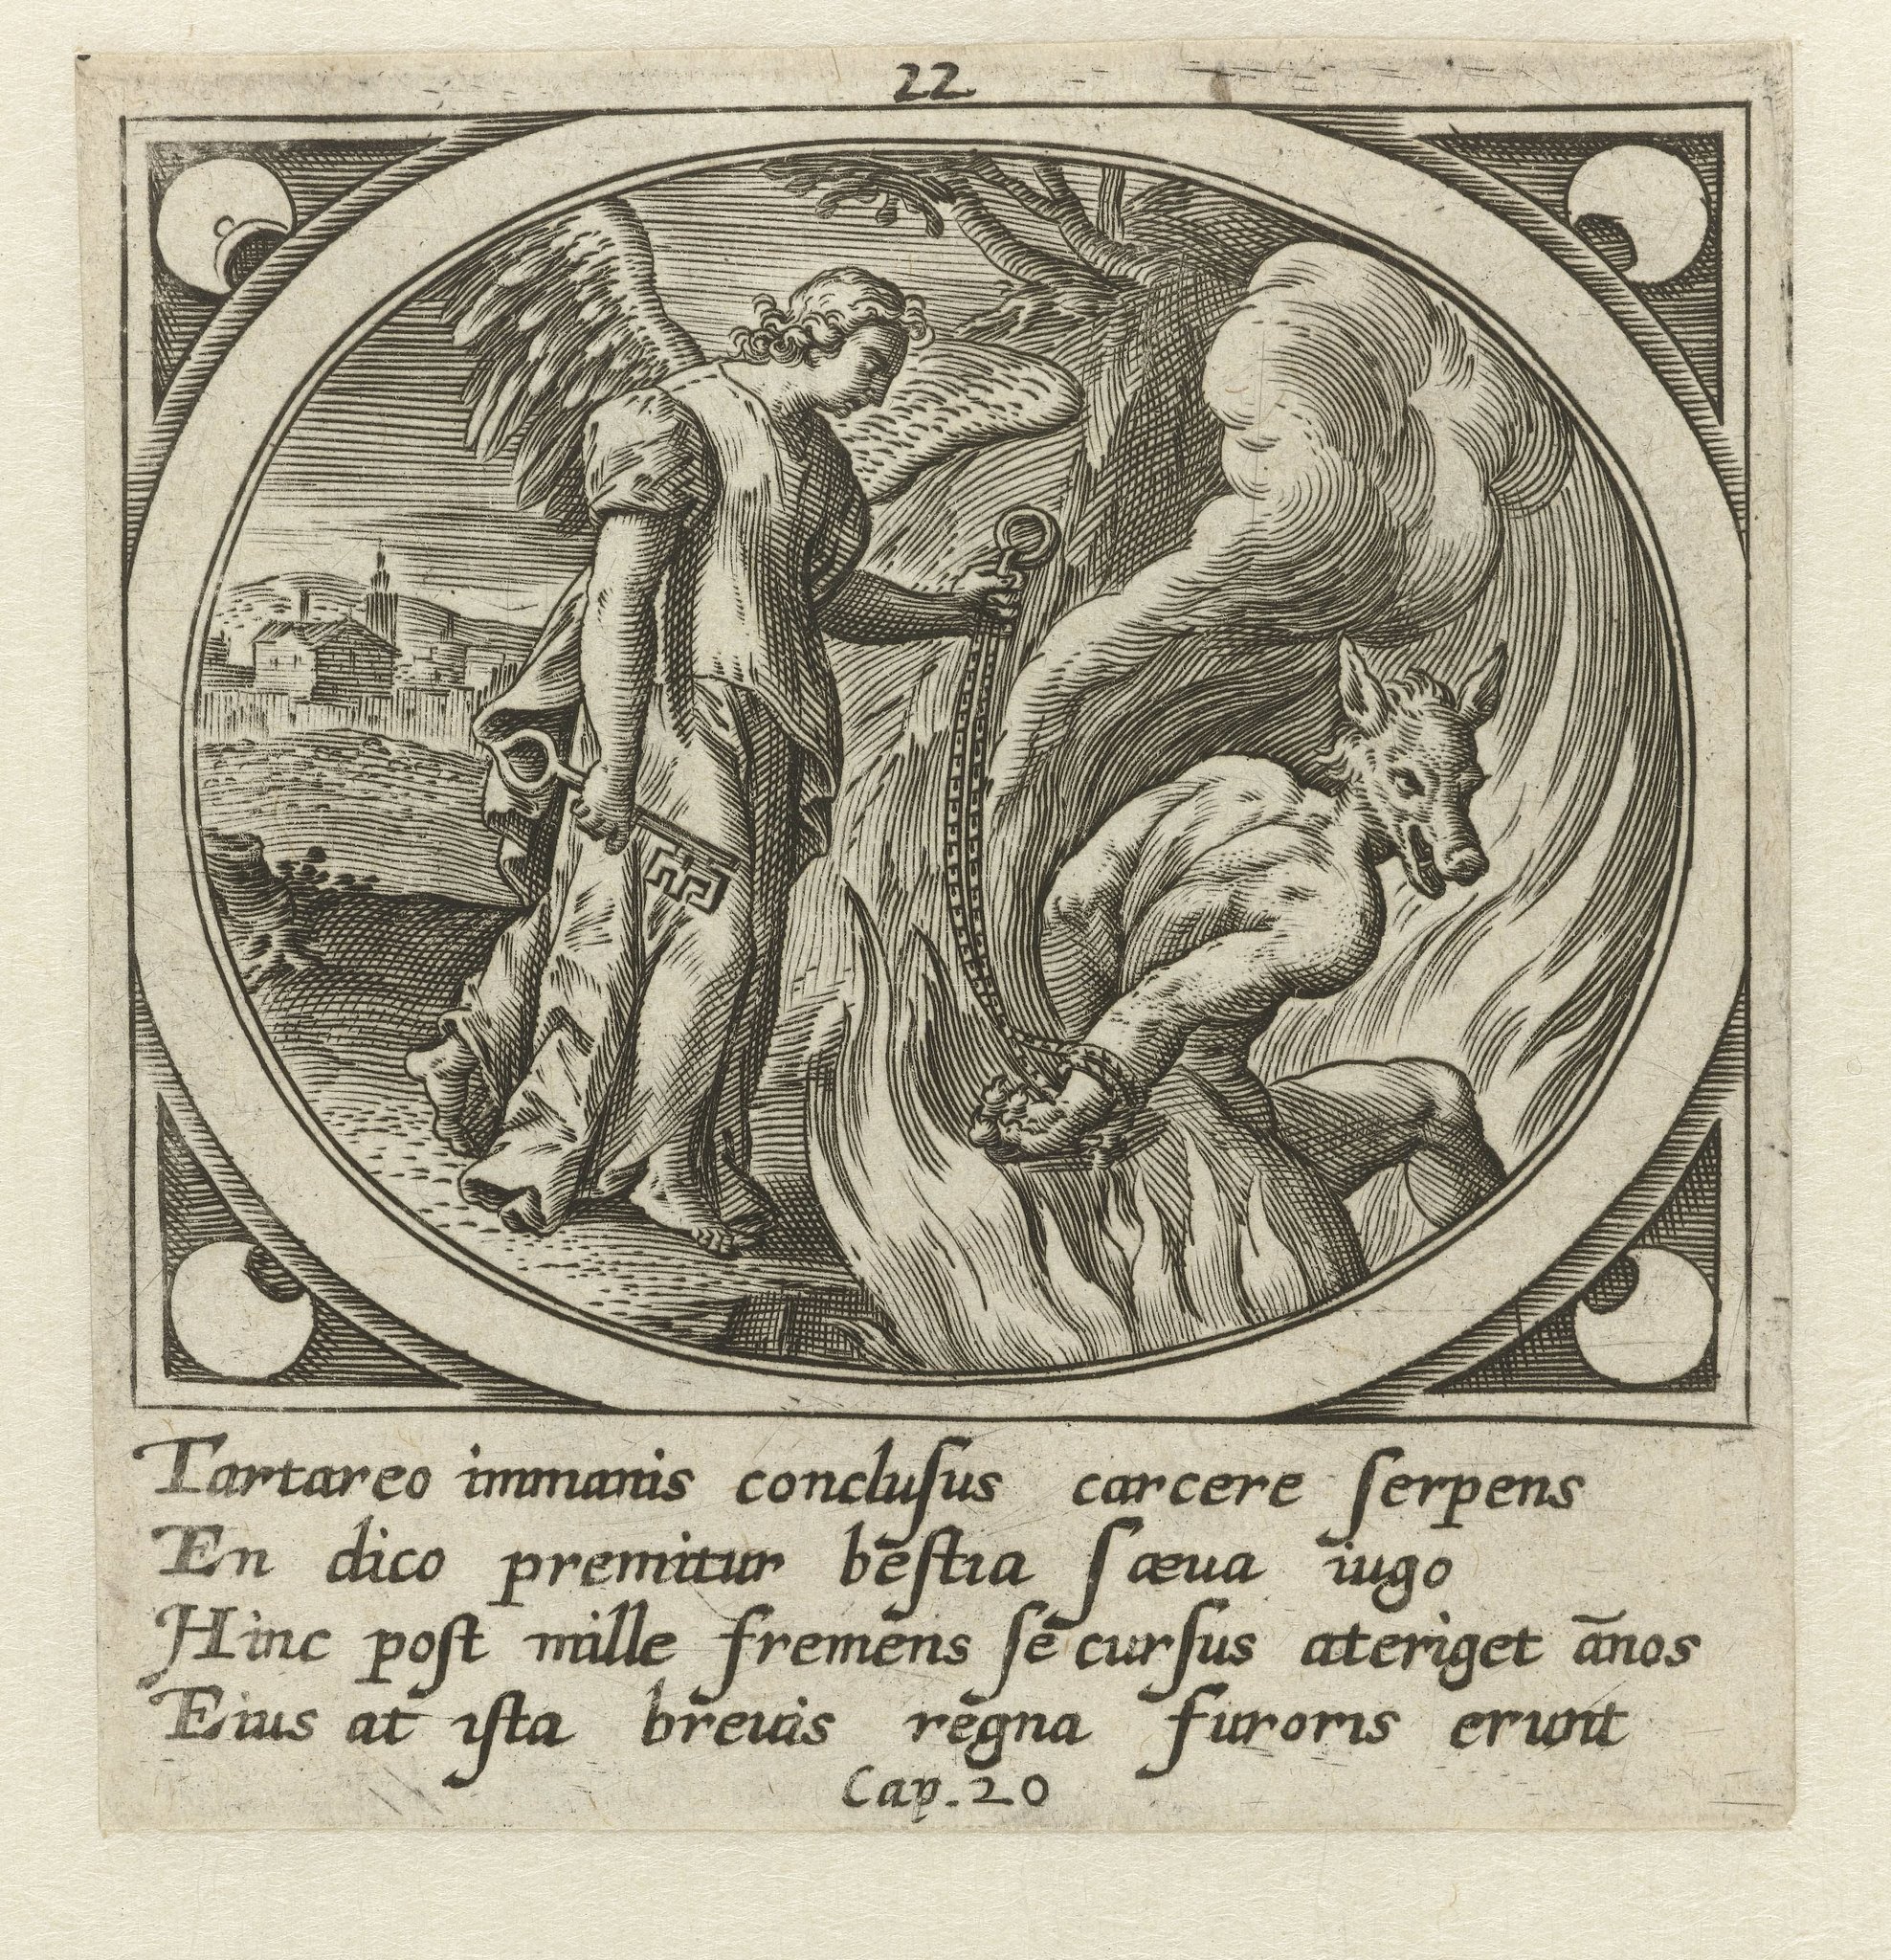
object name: print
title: Openbaring van Johannes op Patmos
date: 1585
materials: paper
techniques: engraving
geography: antwerp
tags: an angel with a key and a chain binds the dragon (satan) and casts him into the pit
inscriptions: collector's mark: Lugt 2760, collector's mark: Lugt 2228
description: Een engel met de sleutel van de onderaardse diepte ketent de draak (voor duizend jaren) en stopt hem in een onderaardse put met vuur. In de marge een vierregelig onderschrift in het Latijn. Tweeëntwintigste prent uit een serie van vierentwintig met de openbaring van Johannes op Patmos.